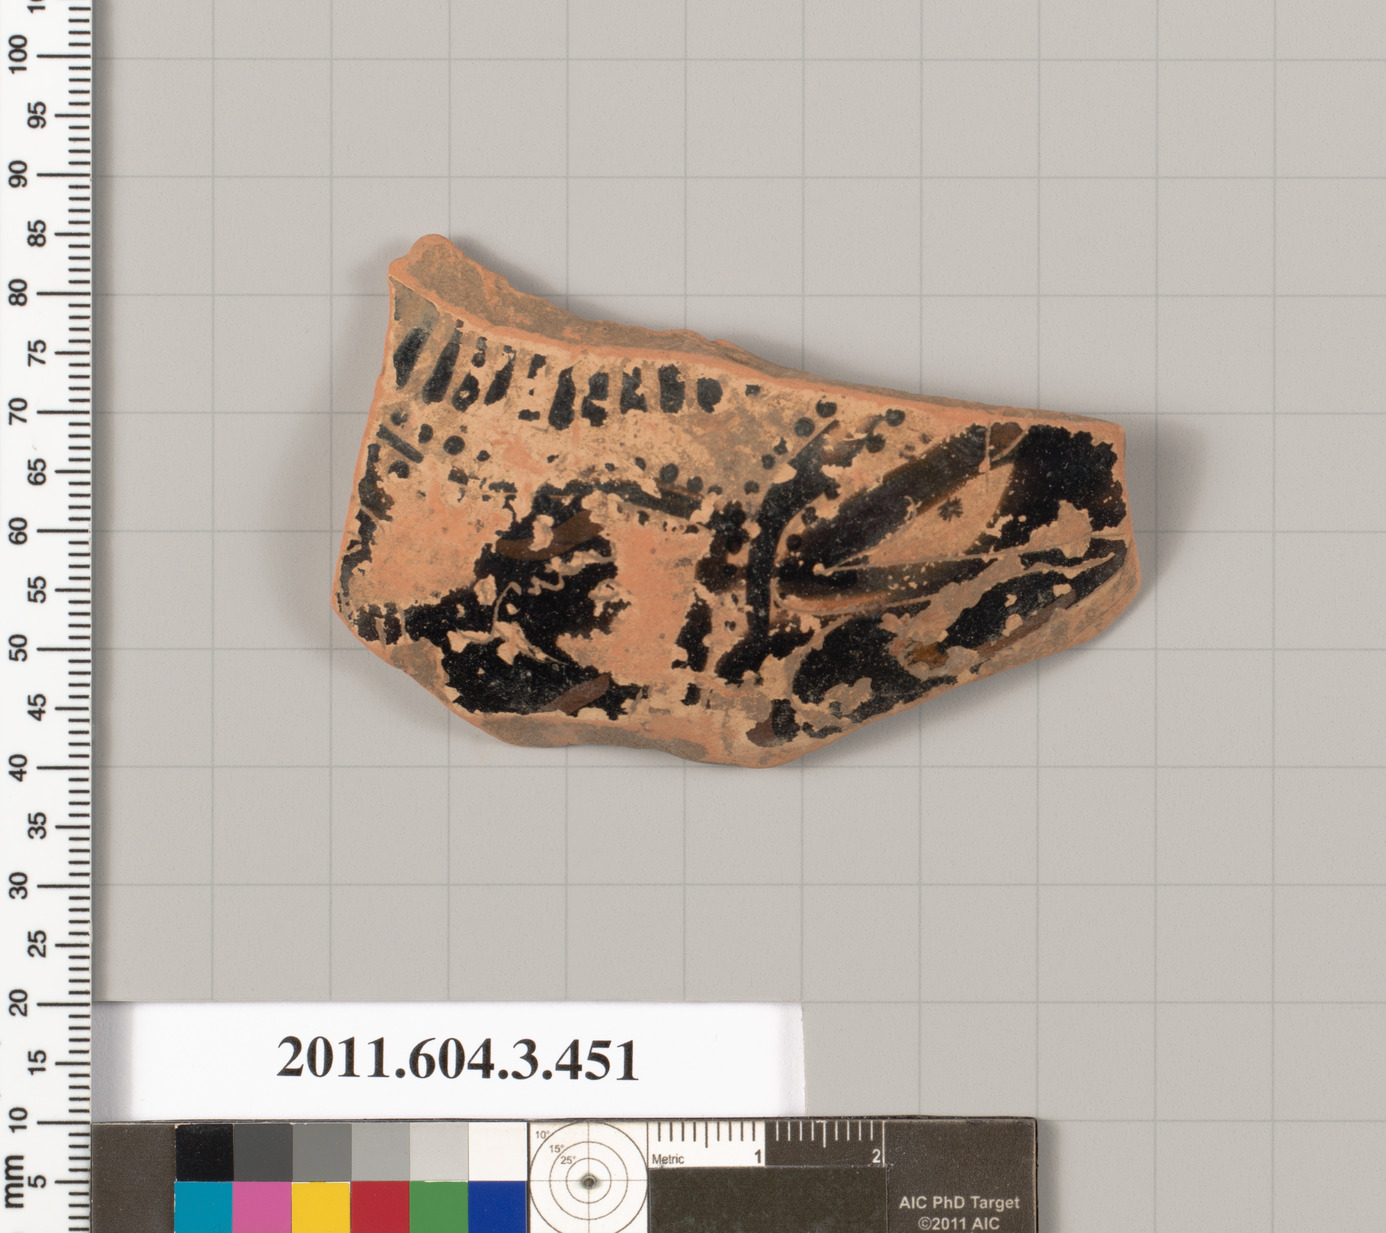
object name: neck amphora fragment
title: Terracotta fragment of a neck-amphora (jar)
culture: greek, attic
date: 490-480 BCE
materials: terracotta